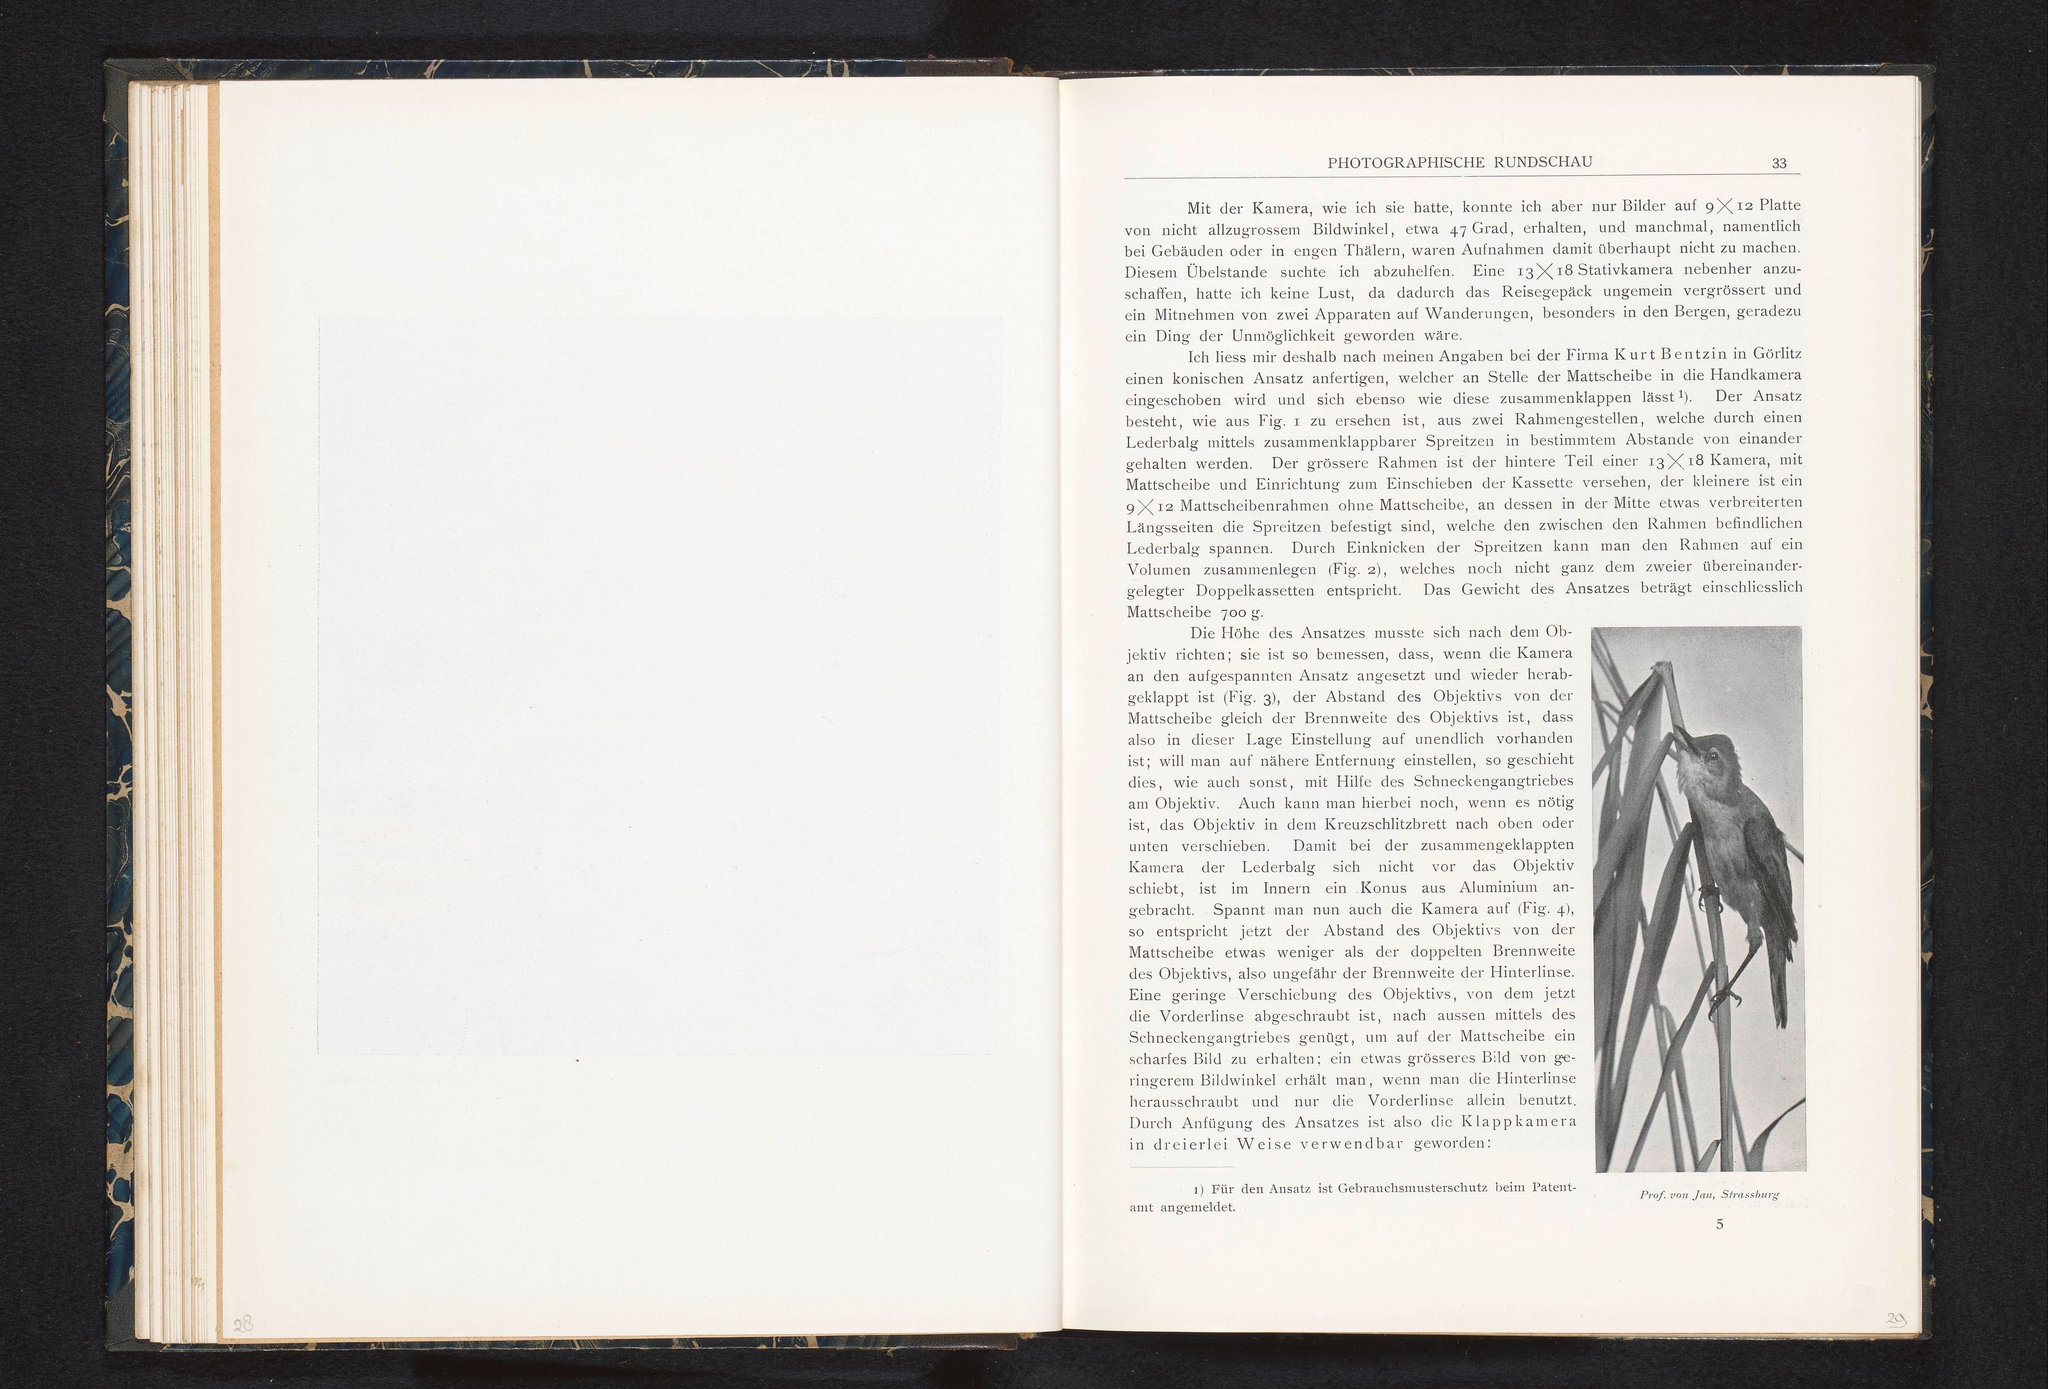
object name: page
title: Vogel op een rietstengel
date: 1896-1901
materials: paper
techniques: autotype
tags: birds, plants and herbs: reed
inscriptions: monogram: ‘LEIPZIG/ S G’